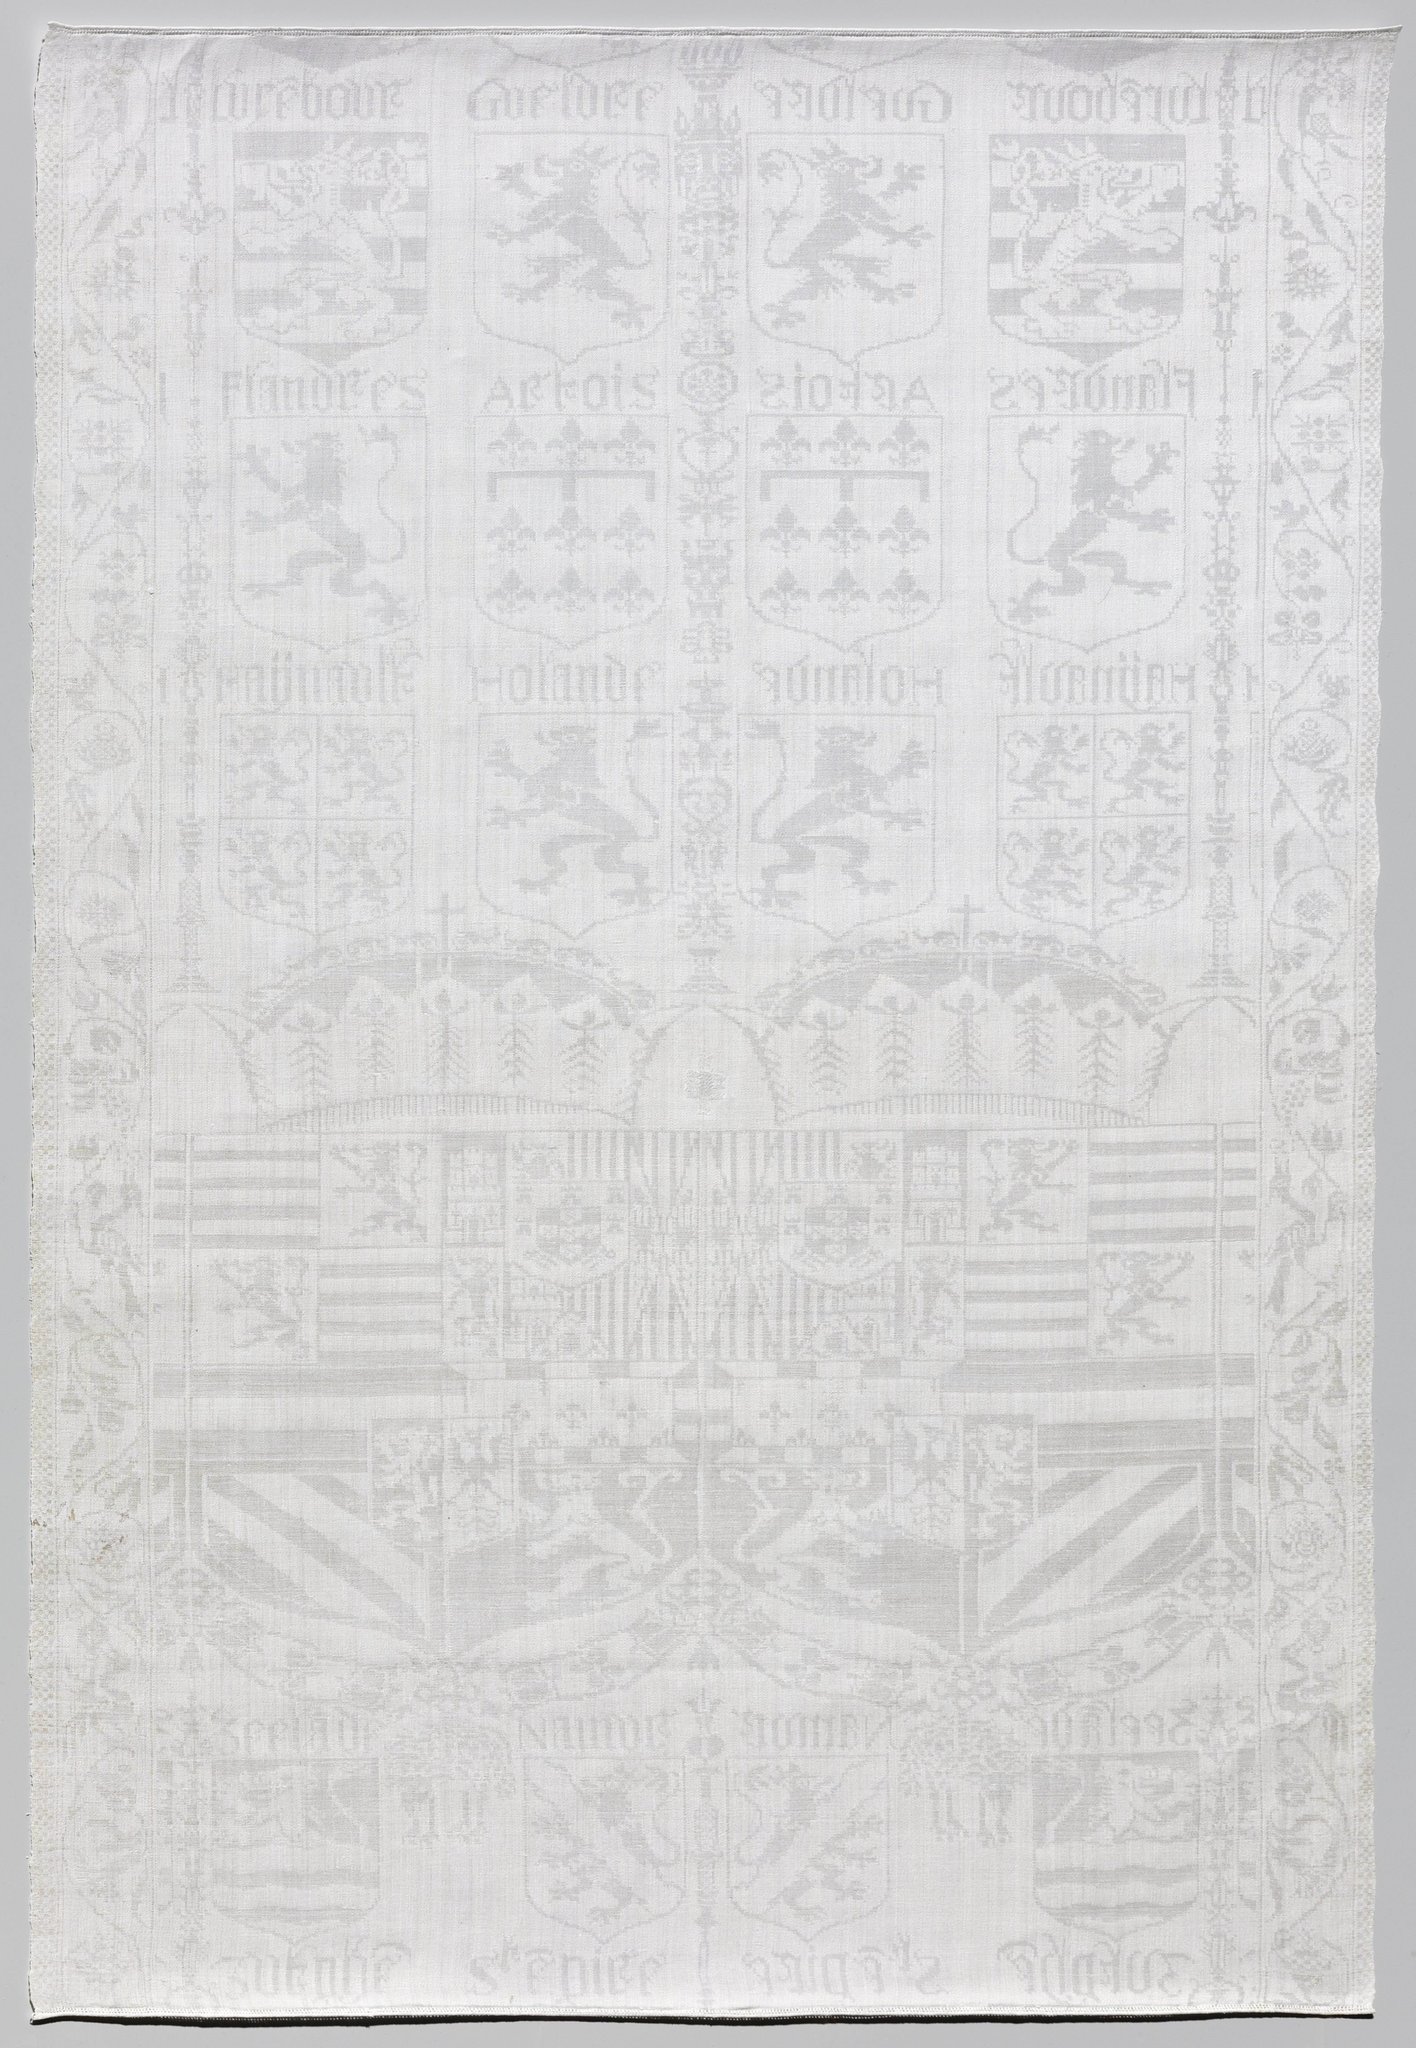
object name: napkin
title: Servet met het Plus Oultre-patroon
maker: Anonymous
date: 1600-1625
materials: linen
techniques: damask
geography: kortrijk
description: Wit linnendamasten servet met een plus oultre patroon, merk kroon HW 23 en K.